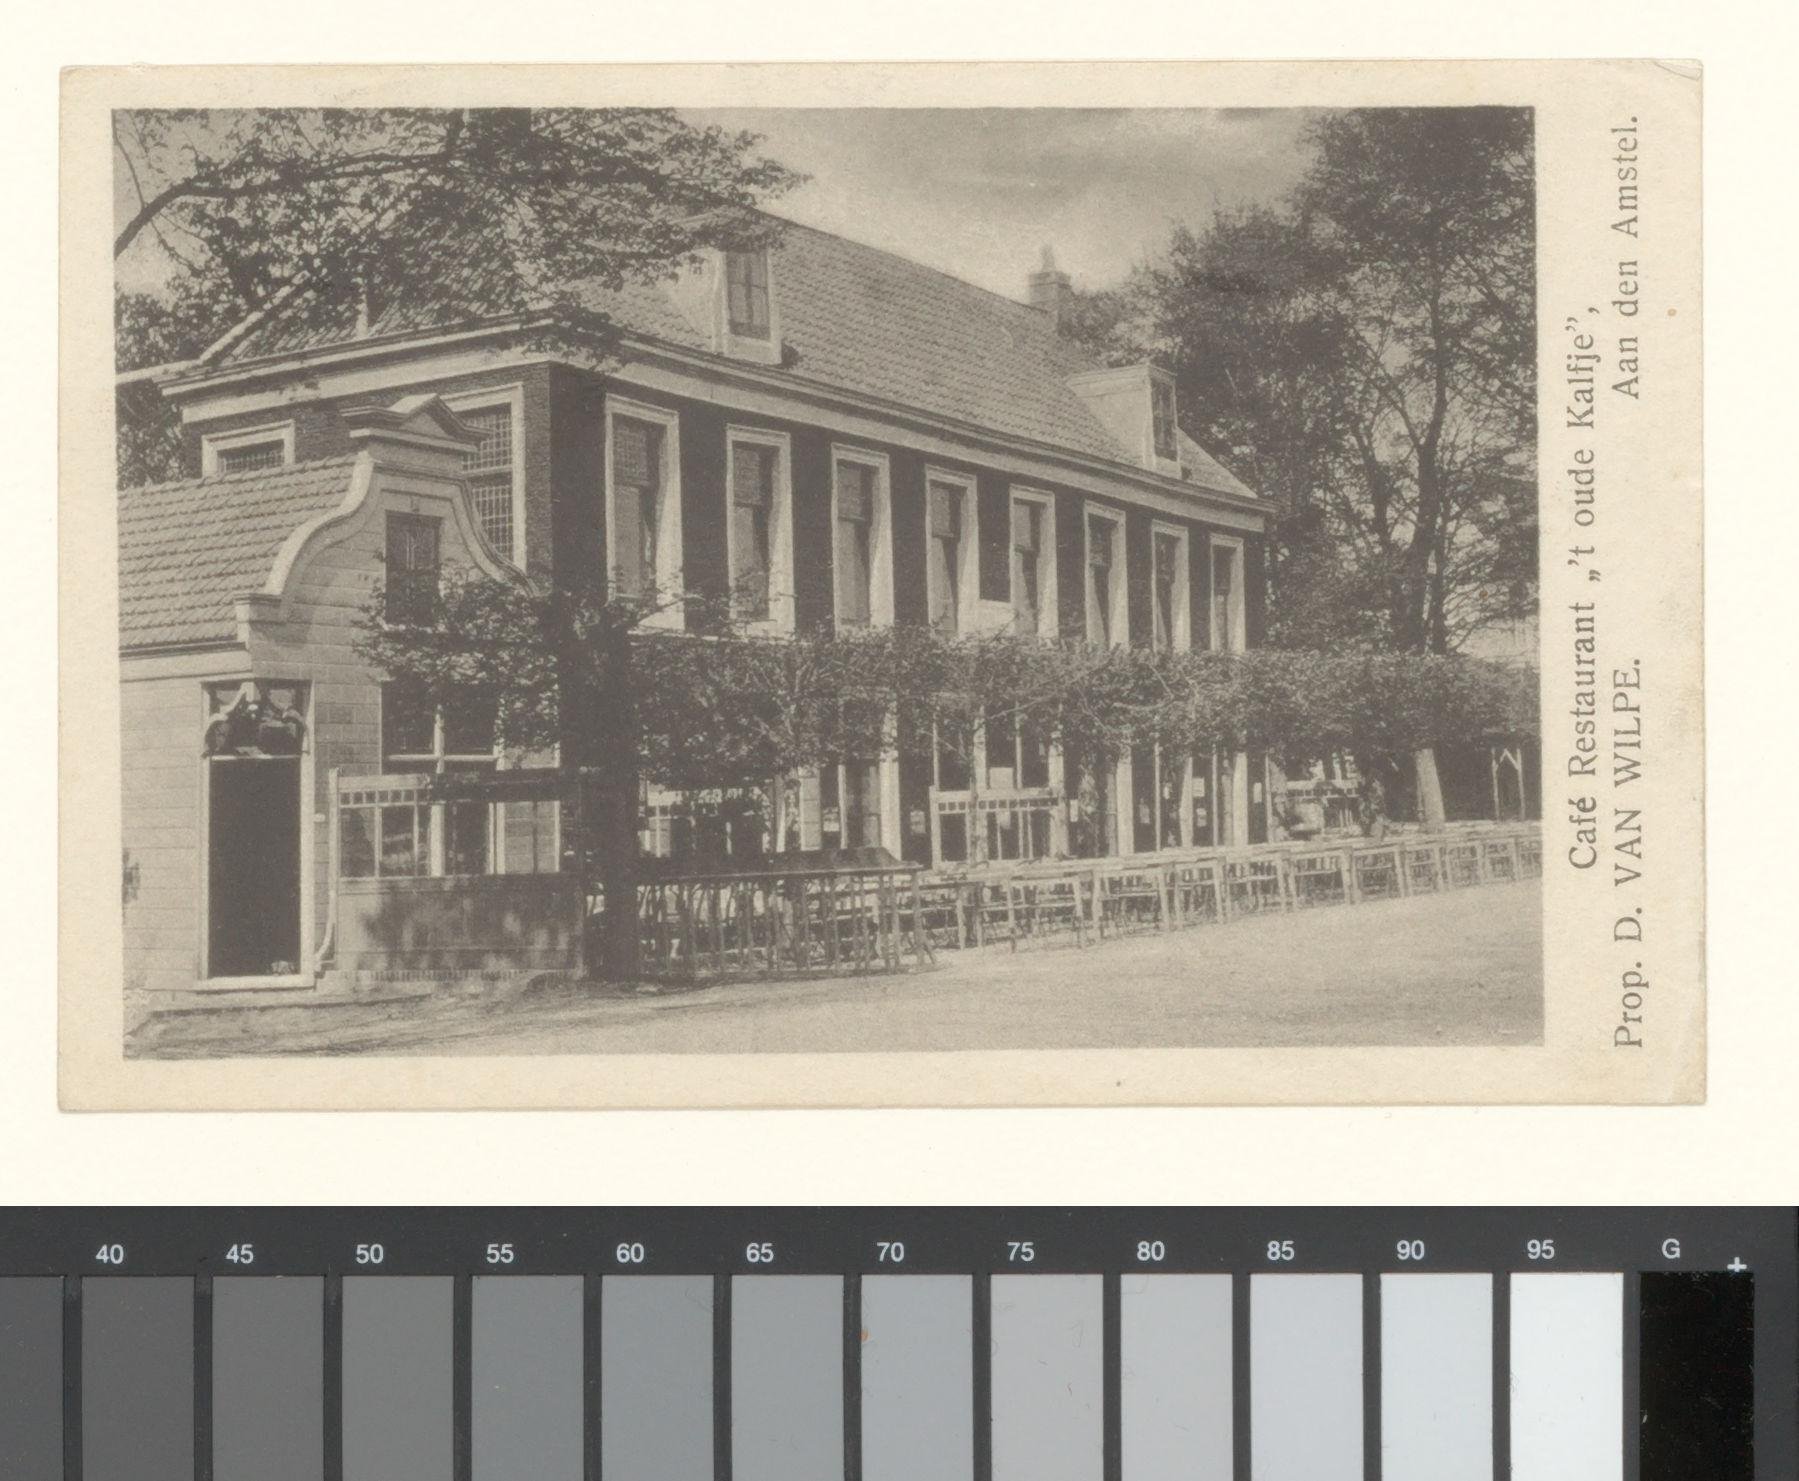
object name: ansichtkaart, prentbriefkaart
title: Gezicht op café-restaurant Oud Kalfje aan de Amsteldijk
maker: Anonymous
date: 1914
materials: paper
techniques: photograph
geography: amsterdam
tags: city-view in general; 'veduta', road, path, restaurant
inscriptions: number: ‘58’, inscription: ‘Heel veel groeten (...) Hooftlaan 1 / Bussum’